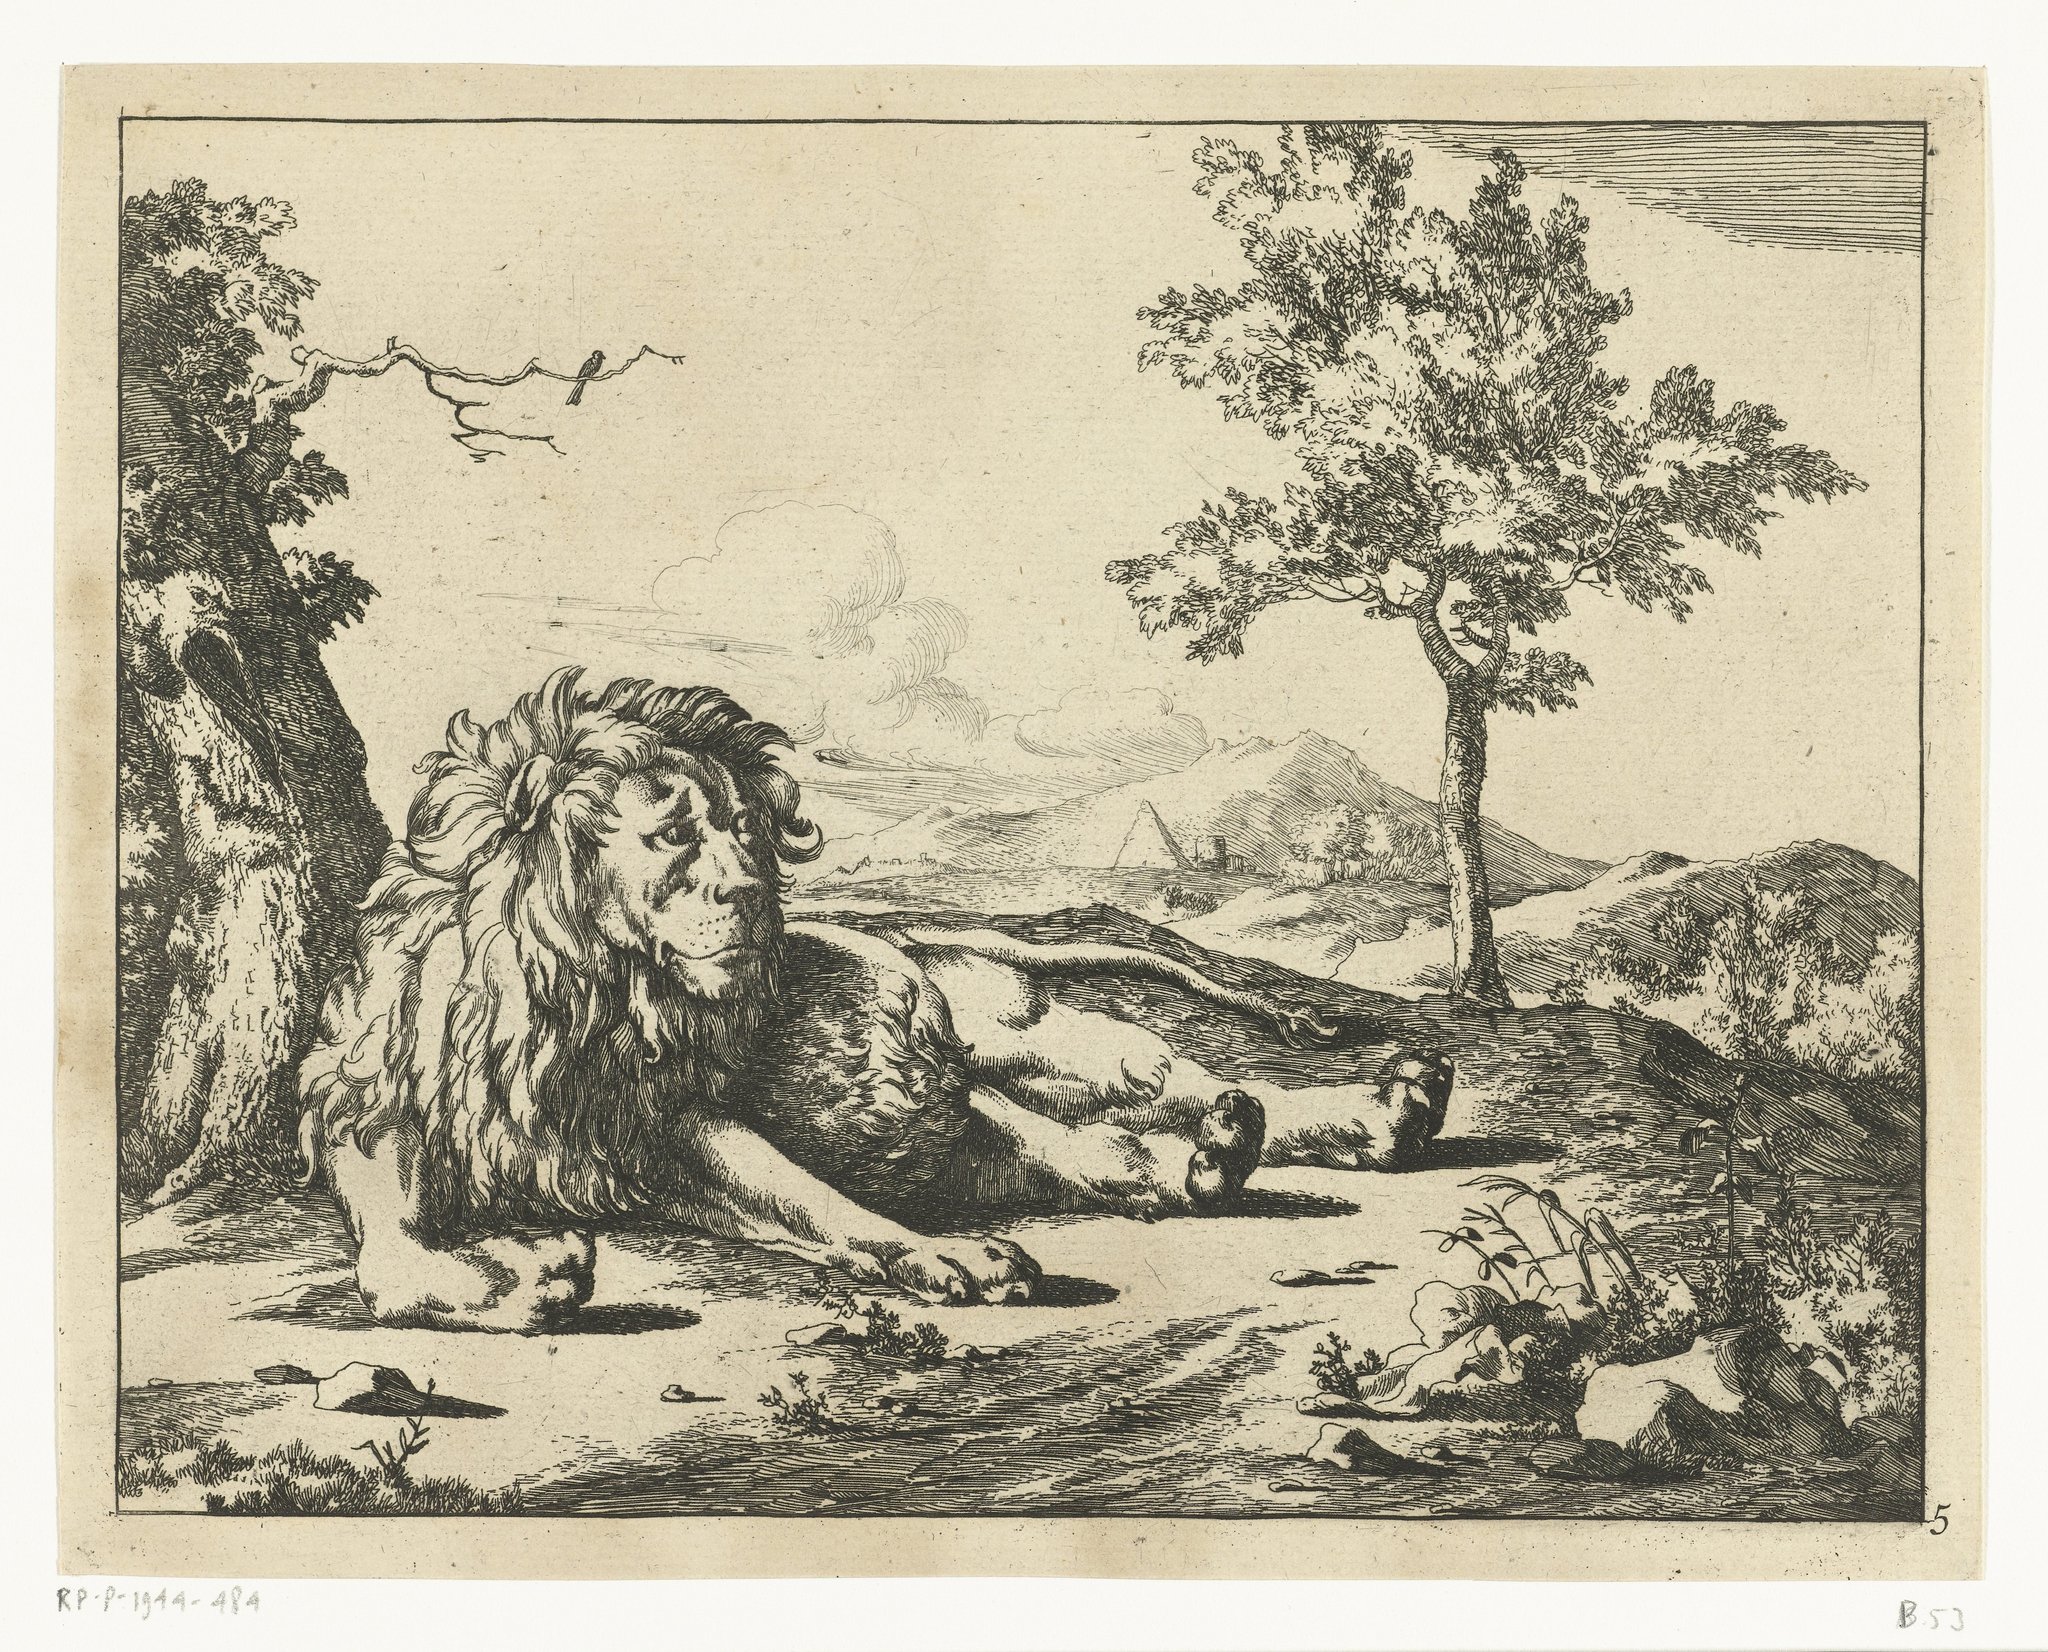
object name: print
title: Leeuwen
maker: marcus de bye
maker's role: print maker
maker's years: 1639-1688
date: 1664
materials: paper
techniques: etching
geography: the hague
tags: beasts of prey, predatory animals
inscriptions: collector's mark: Lugt 2228